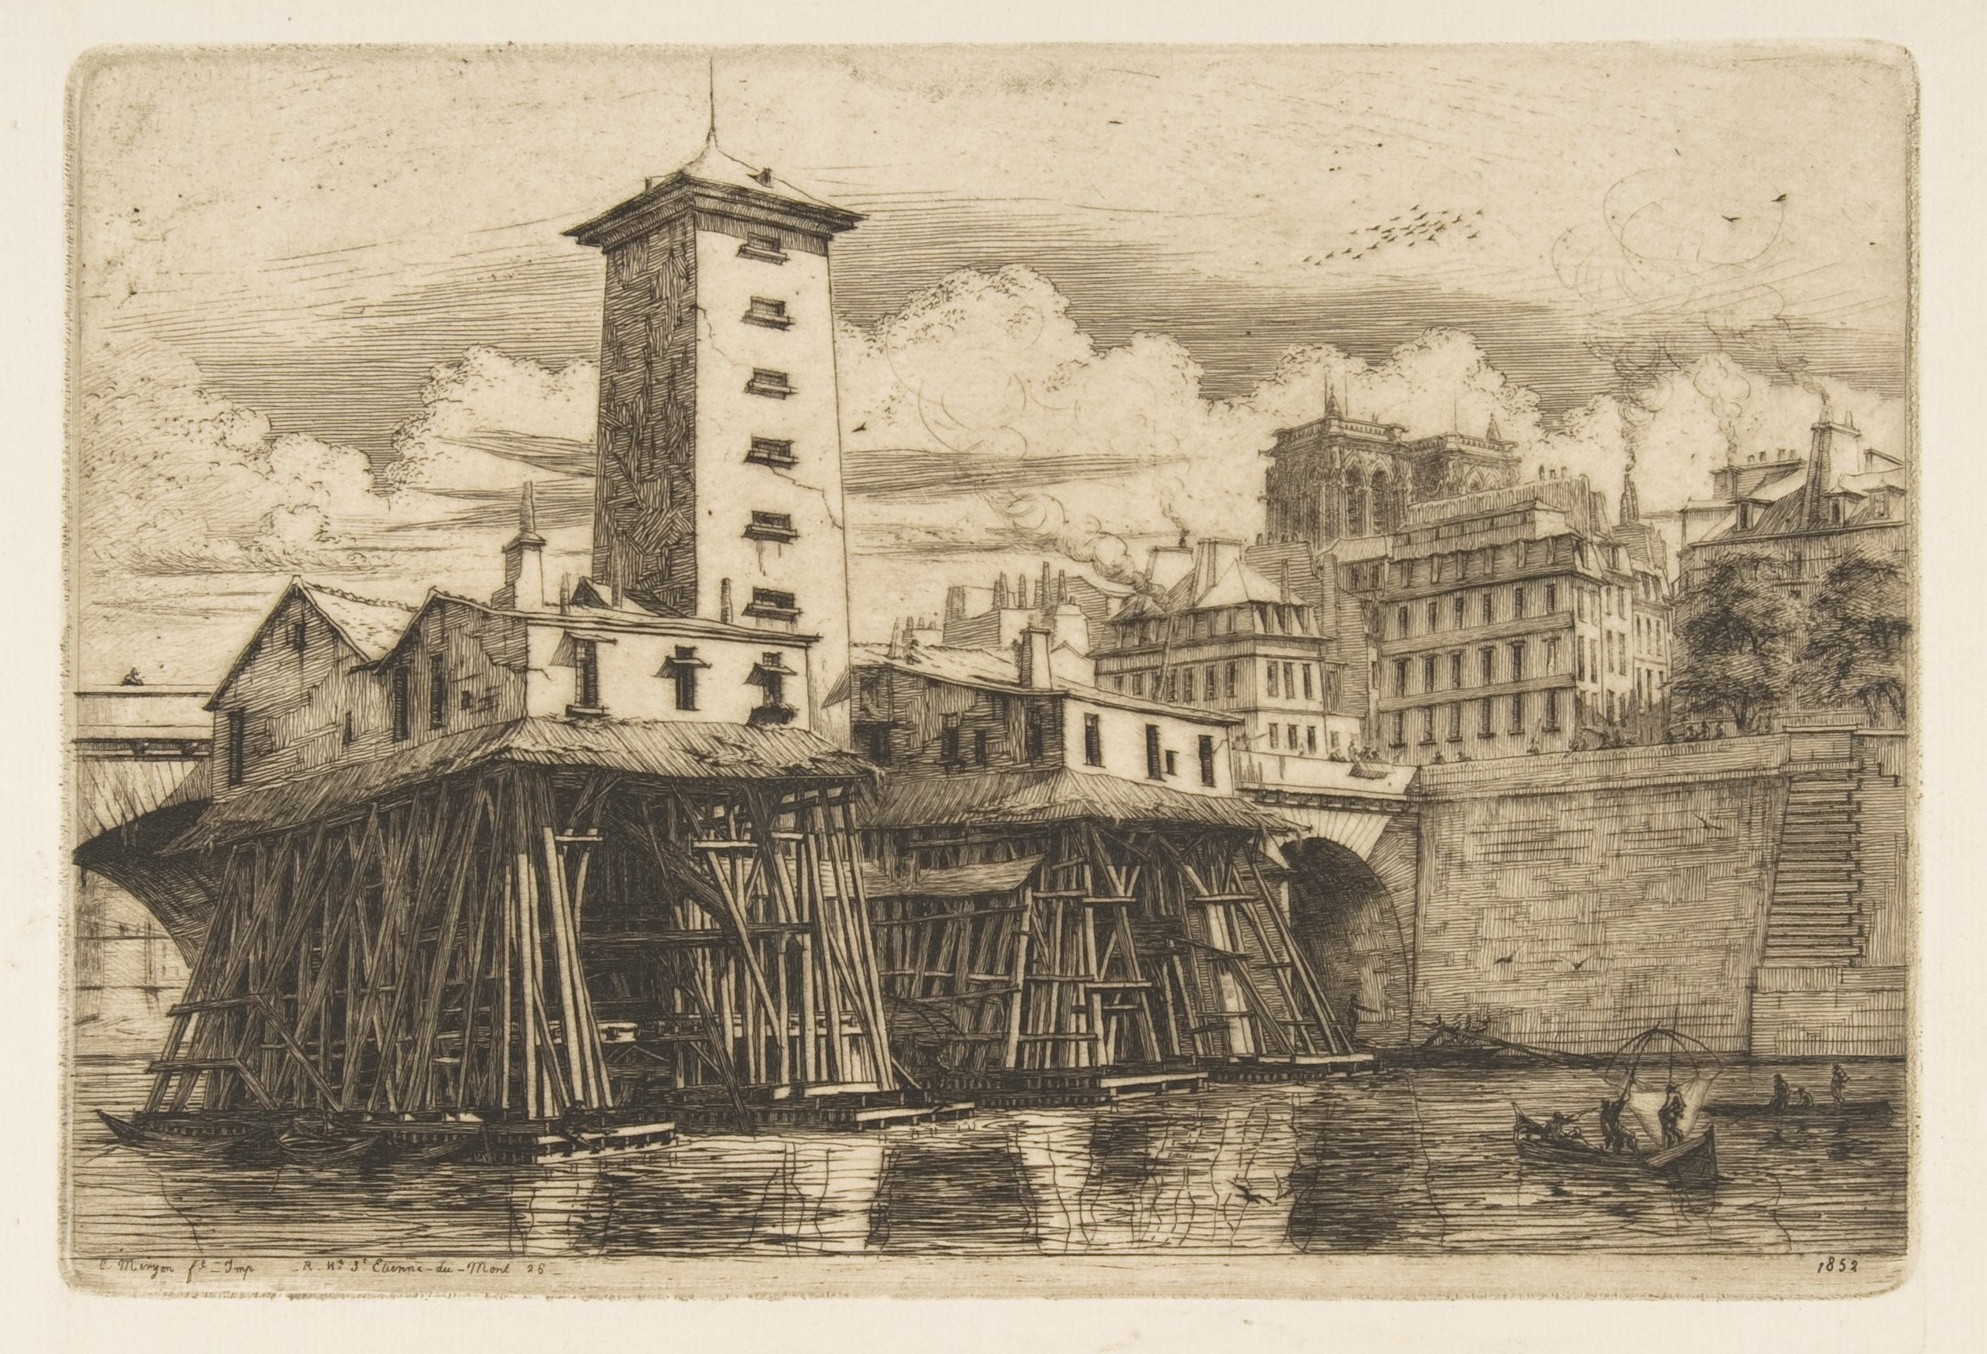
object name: print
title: The Notre-Dame Pump, Paris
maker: charles meryon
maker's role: artist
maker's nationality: french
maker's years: 1821-1868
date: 1852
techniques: etching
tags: buildings,towers,boats,paris